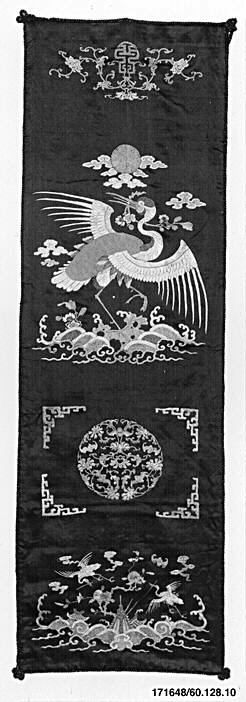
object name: chair strip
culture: chinese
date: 1701-1733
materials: linen, metal thread, silk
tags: cranes